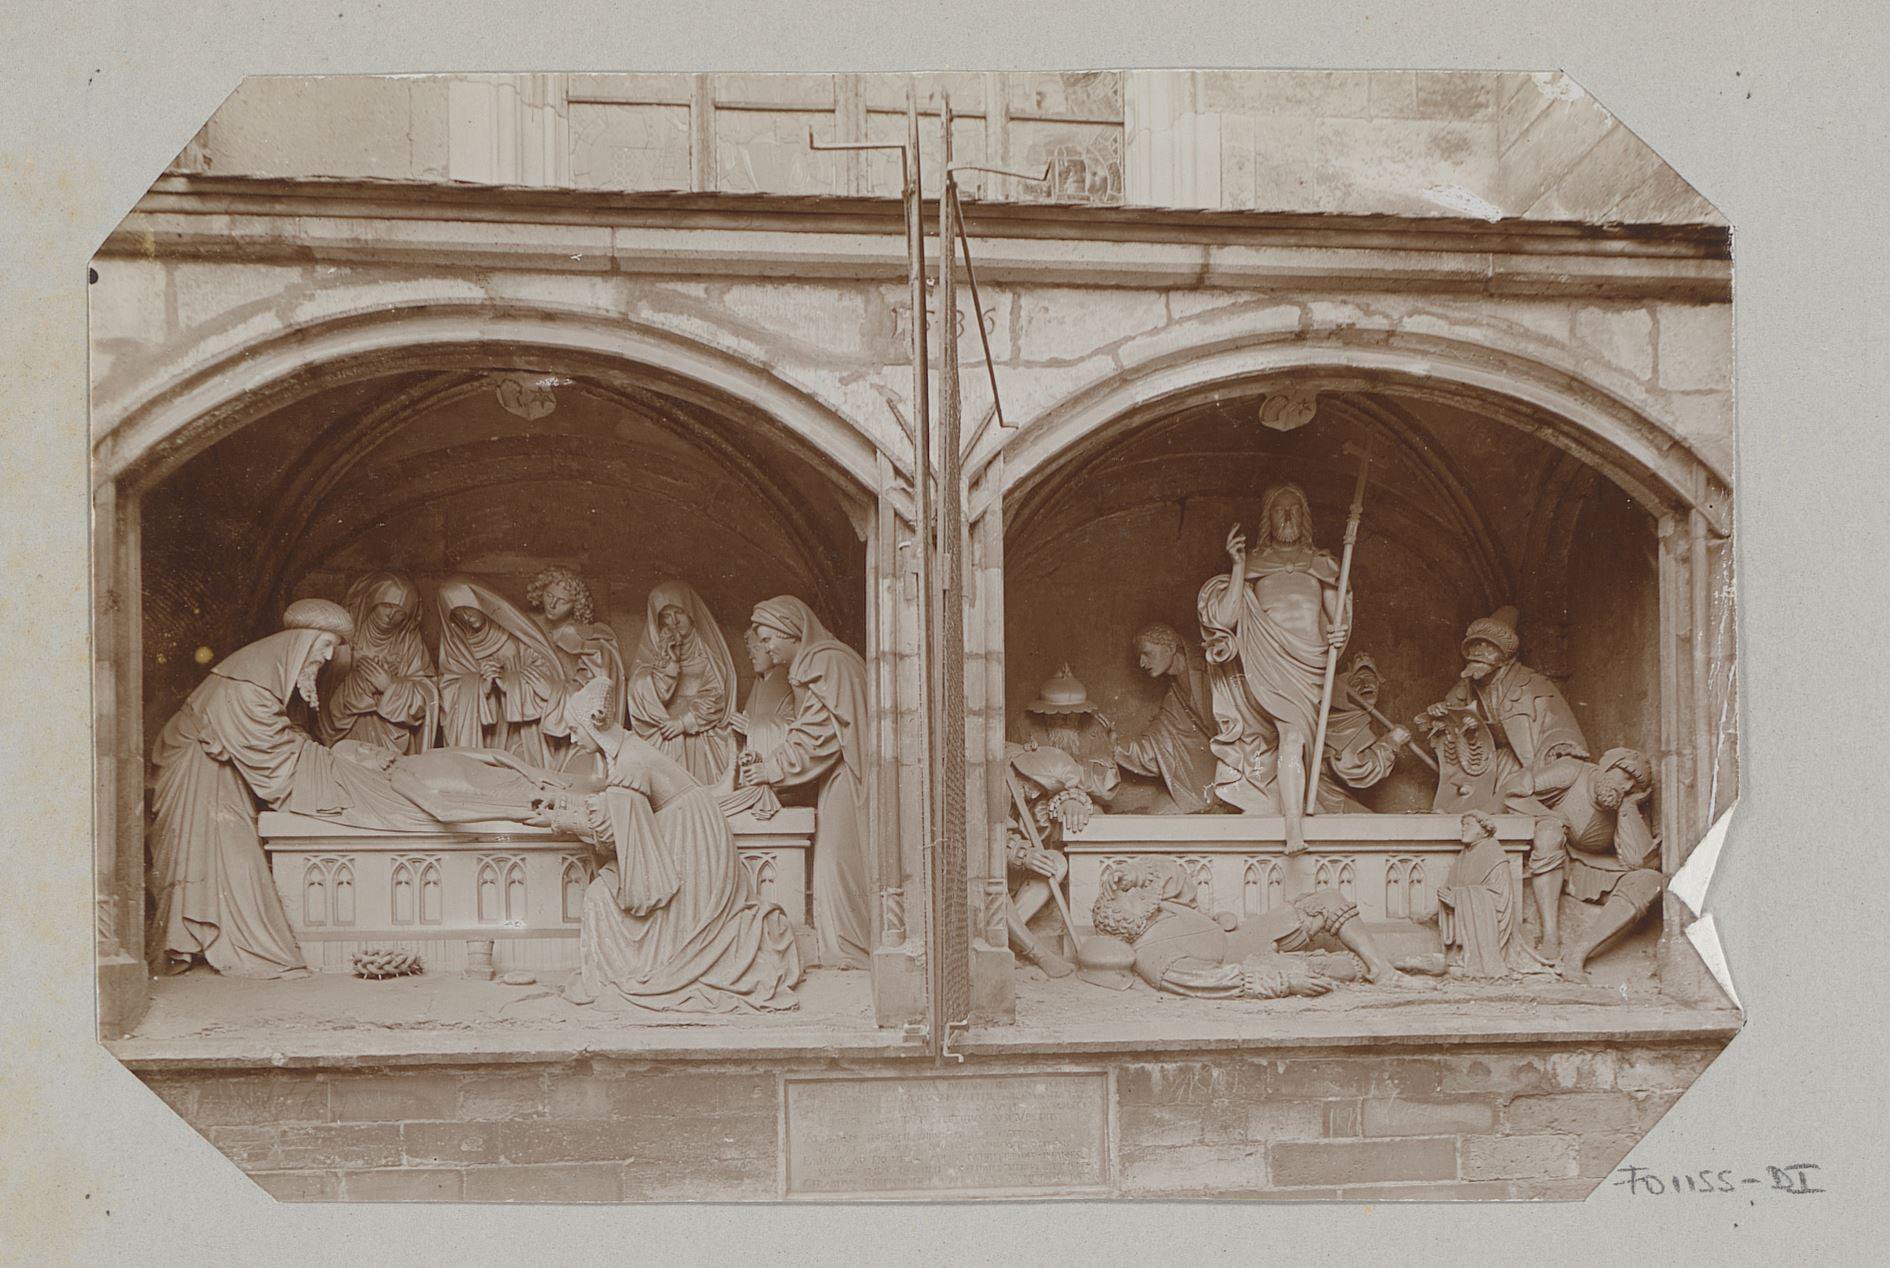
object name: album leaf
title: Reliëf van de graflegging en opstanding van Christus in de Dom van Xanten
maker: Anonymous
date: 1890-1902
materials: photographic support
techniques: collodion silver print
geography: xanten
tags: christ's entombment (possibly by angels)